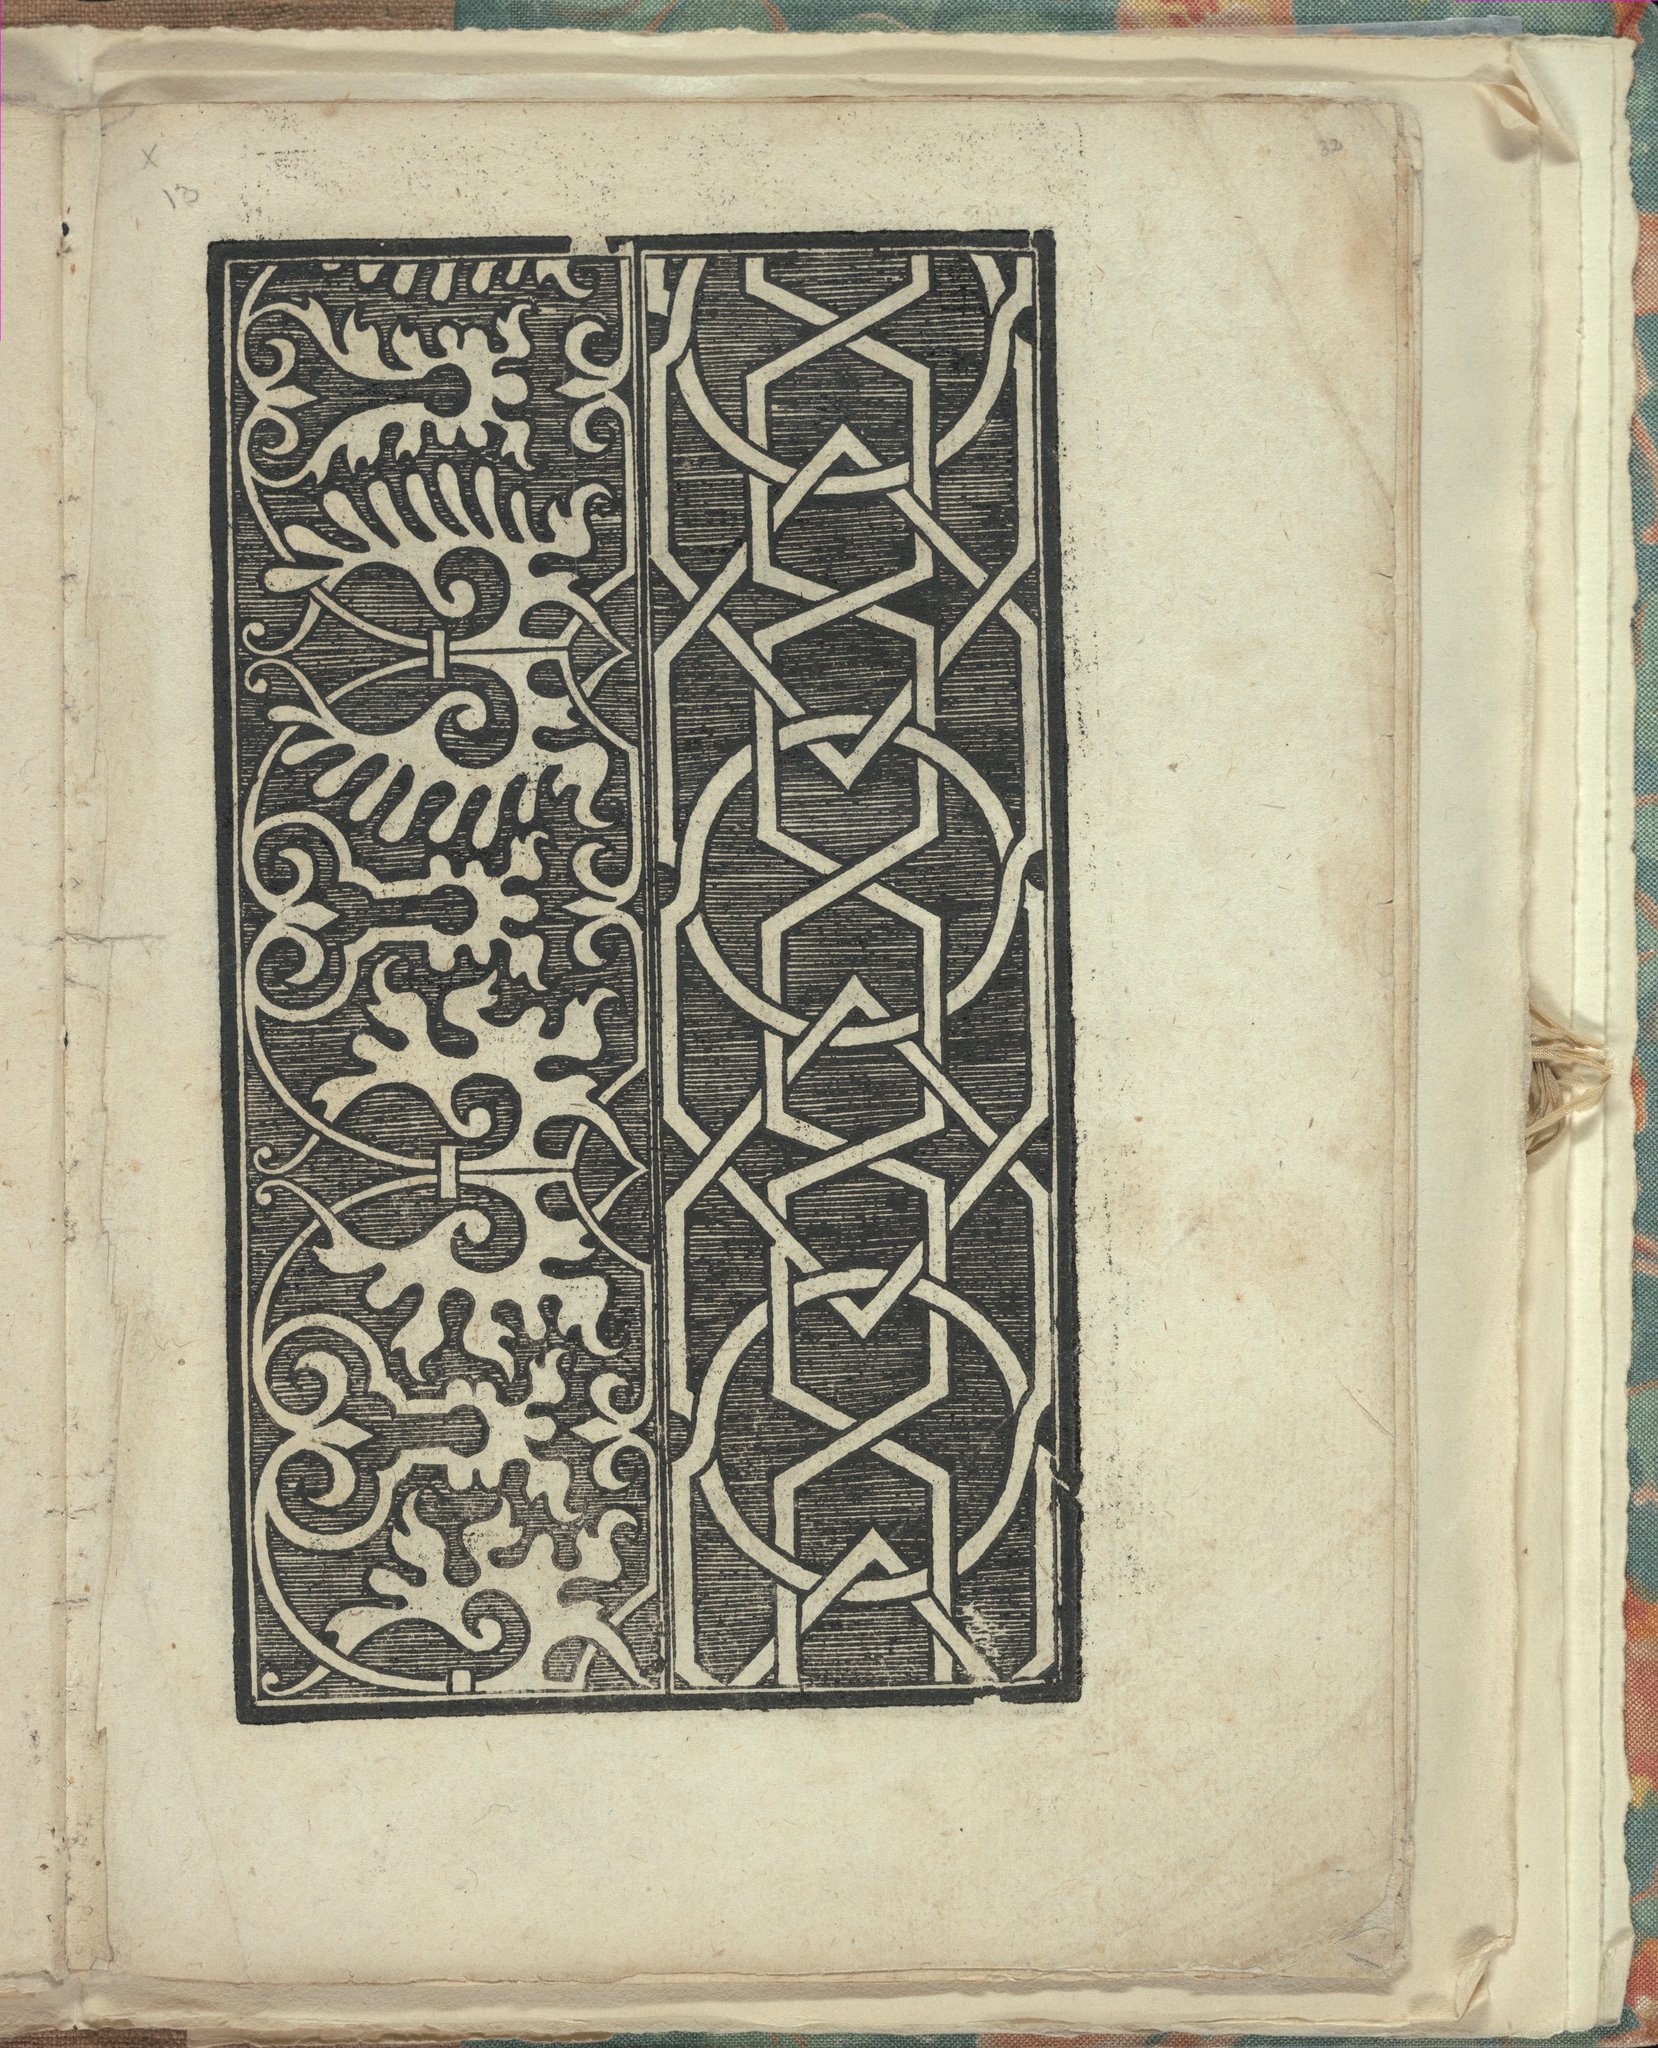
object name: book print ornament architecture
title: Opera Nova Universali intitulata Corona di racammi, page 32 (recto)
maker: giovanni andrea vavassore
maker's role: publisher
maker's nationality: italian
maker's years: 1530-1573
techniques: woodcut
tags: ornament